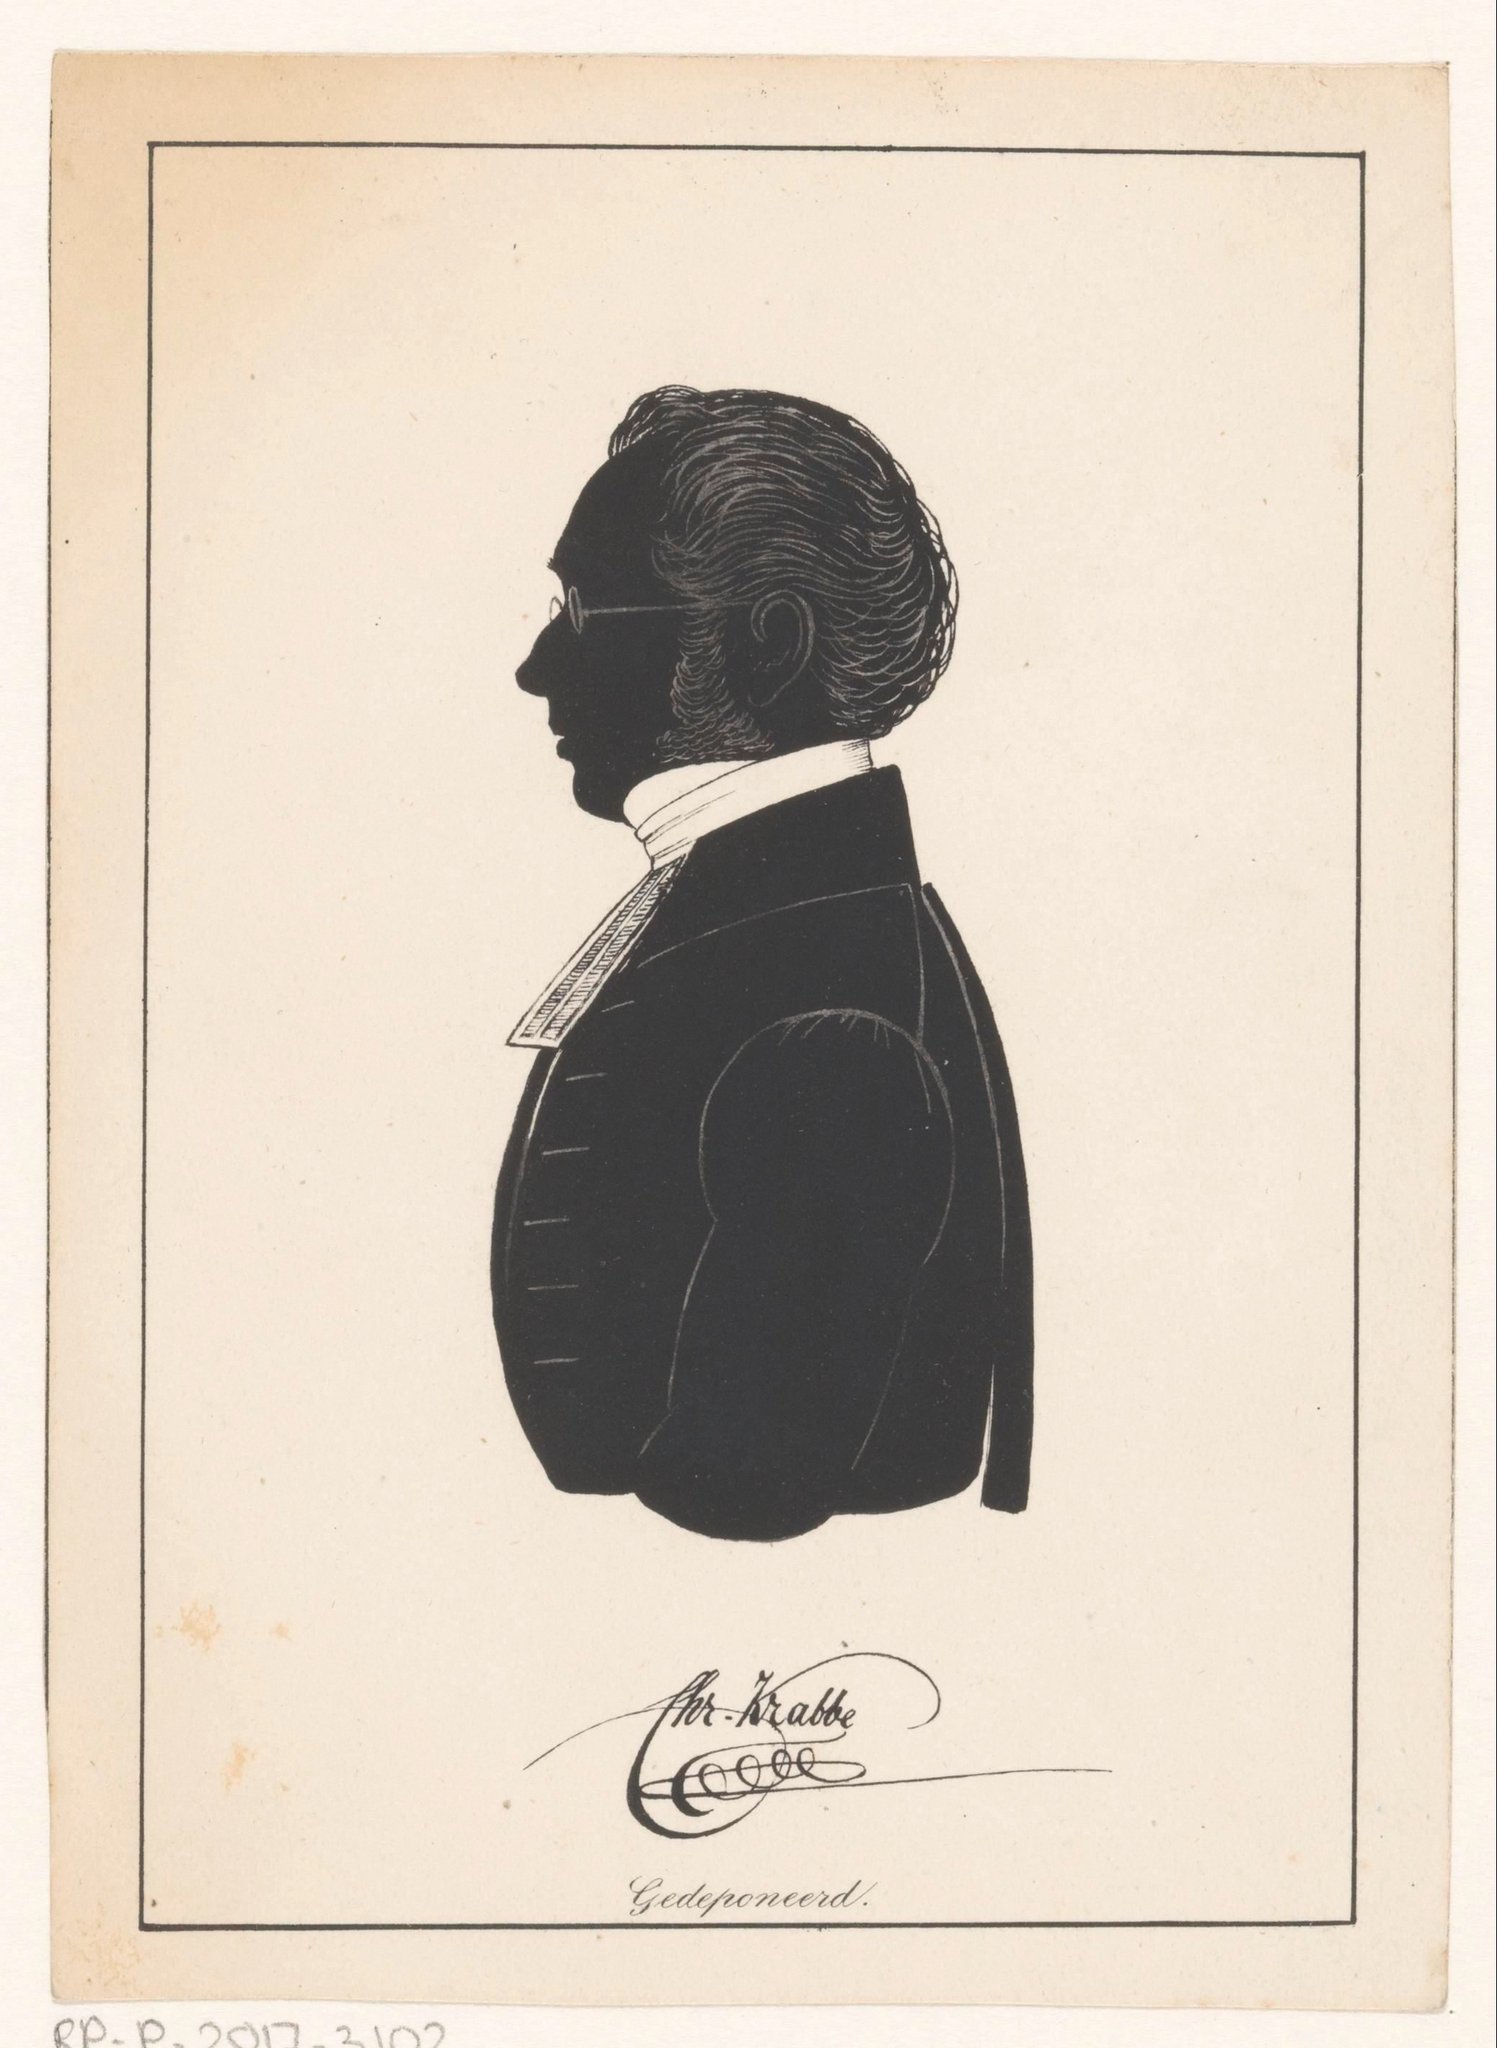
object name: print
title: Silhouetportret van Christiaan Krabbe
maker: pieter barbiers (iv)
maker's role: painter, print maker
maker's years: 1798-1848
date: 1809-1848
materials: paper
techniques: hand coloring, lithograph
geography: netherlands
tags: the hague, leiden, historical persons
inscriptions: : ‘Gedeponeerd.’, collector's mark: Lugt 2228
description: Onder het portret de signatuur van de geportretteerde.